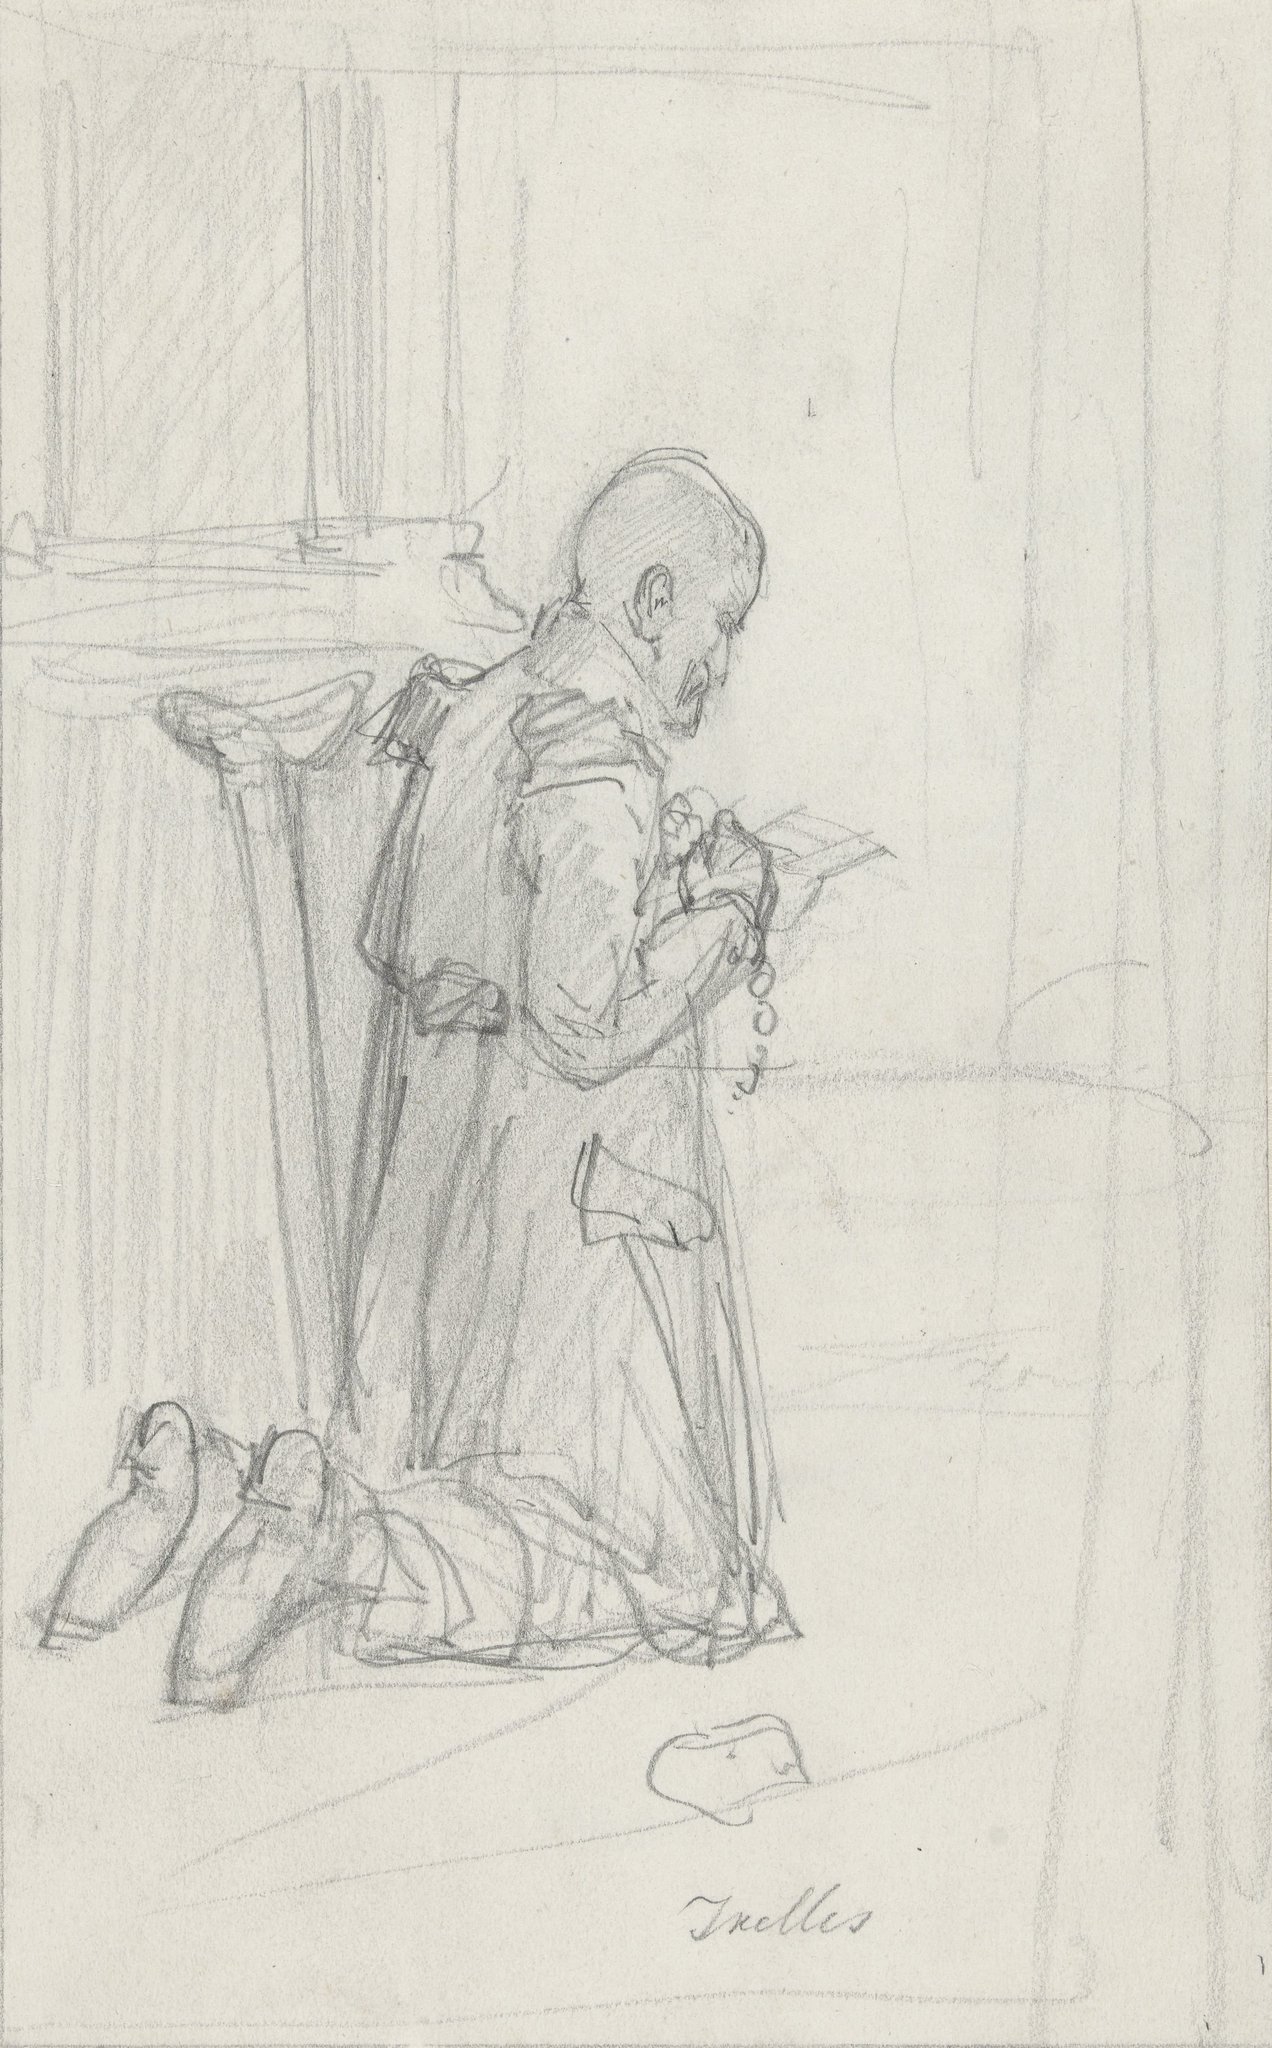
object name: drawing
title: Knielende kreupele, biddend in een kerk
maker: august allebé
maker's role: draughtsman, print maker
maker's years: 1838-1927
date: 1848-1927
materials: paper, pencil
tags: crutches, person with a physical disability, saying the rosary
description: De krukken van de man staan naast hem tegen de bank.